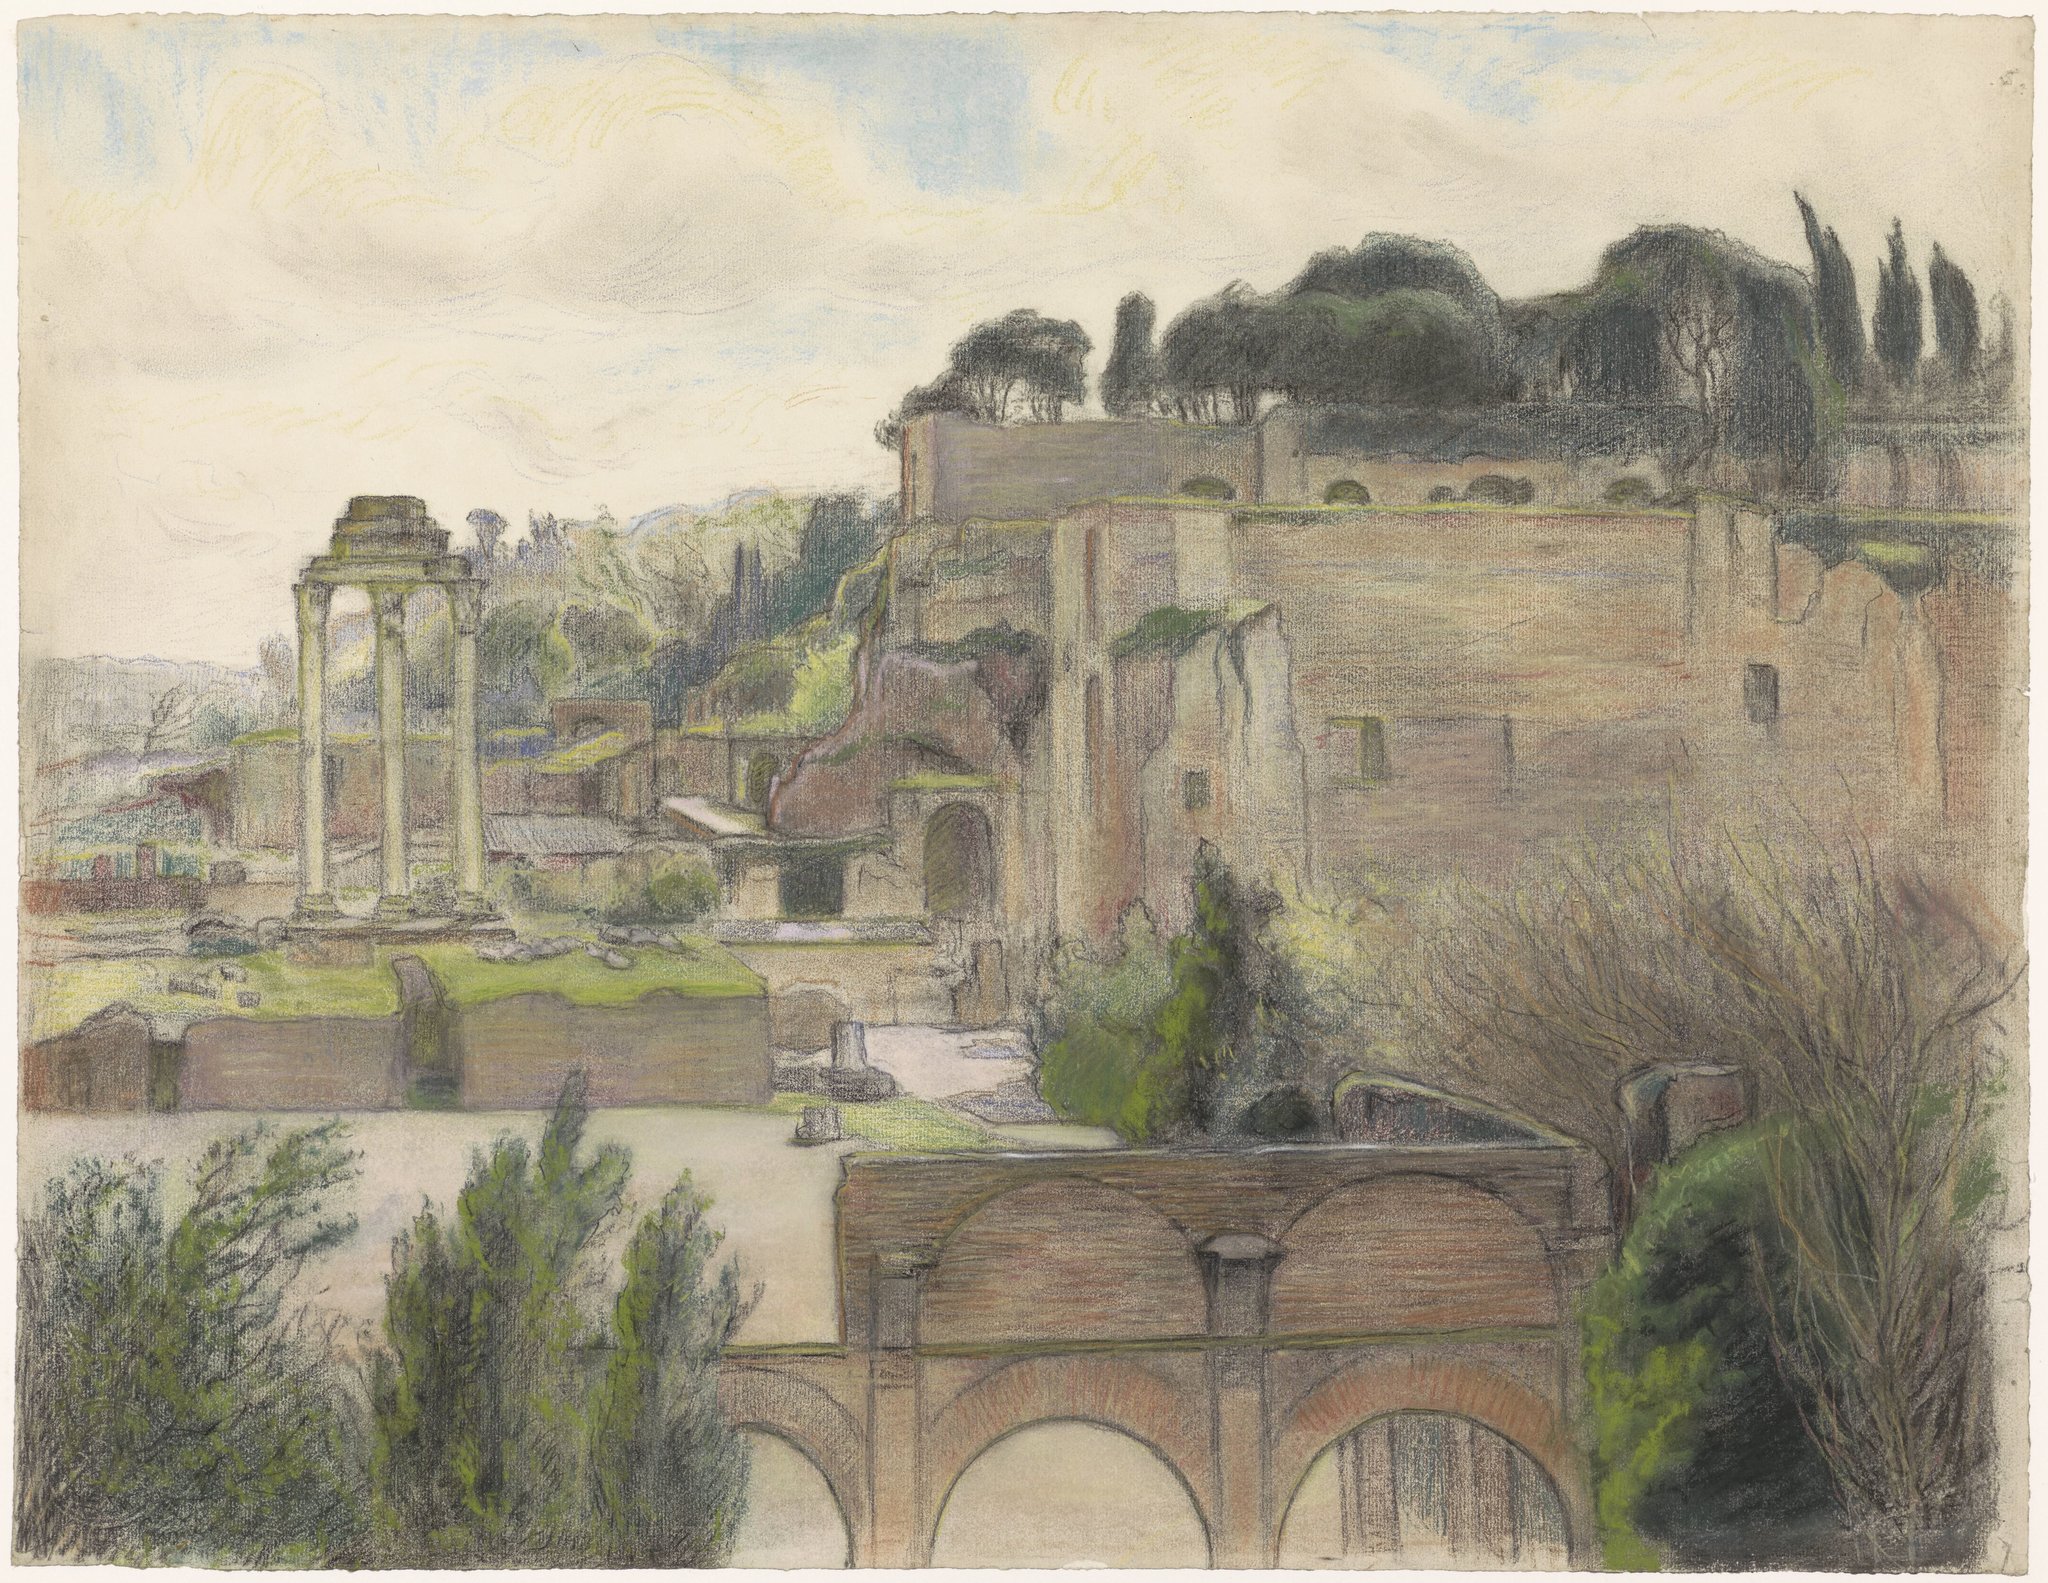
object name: drawing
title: Gezicht op het Forum Romanum en de Palatijn, gezien vanaf de Via Capitolina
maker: frans smissaert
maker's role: draughtsman, print maker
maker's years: 1862-1944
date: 1872-1944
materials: chalk, paper, pastel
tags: ruin of a building ~ architecture, landscape with ruins, rome